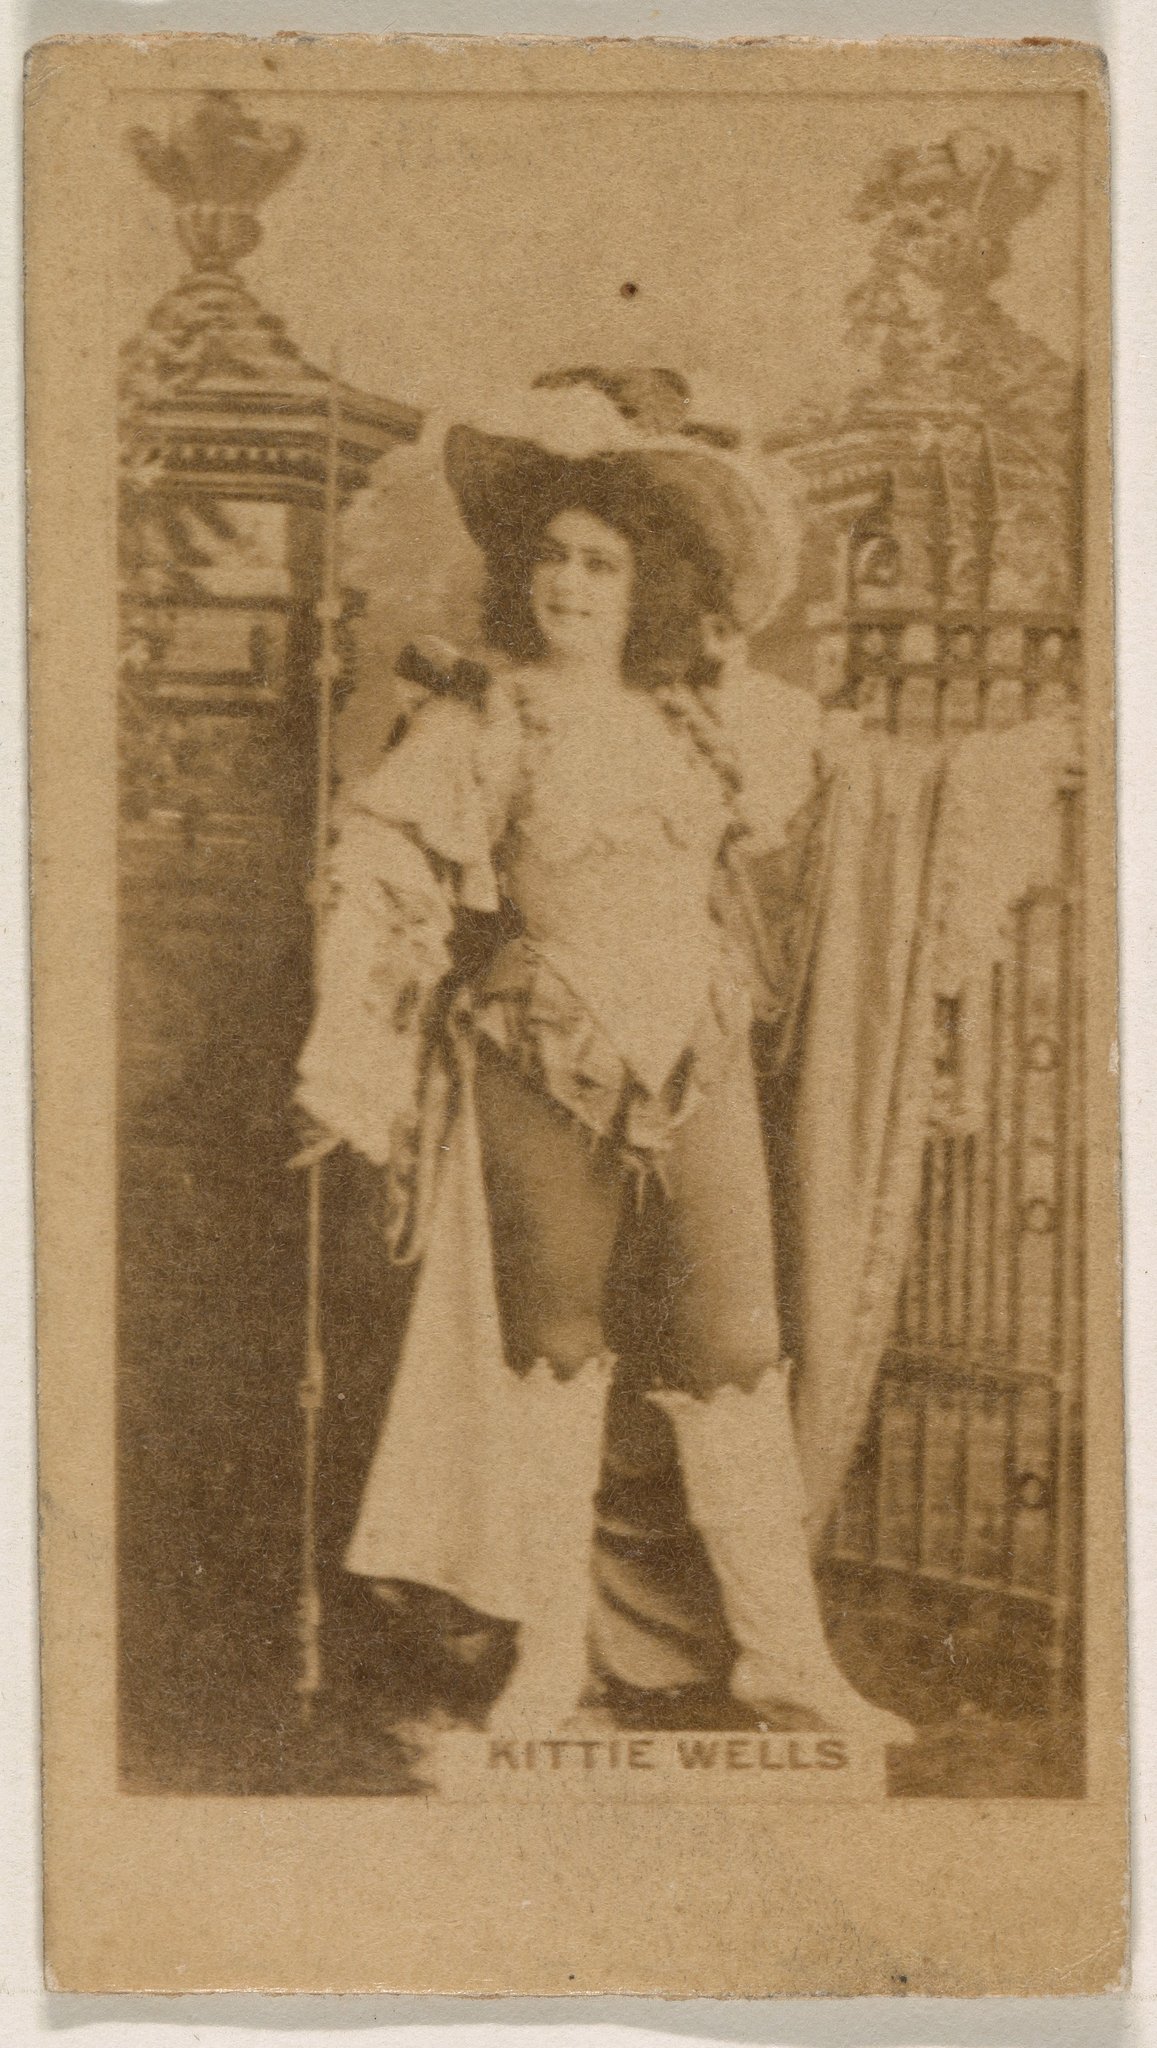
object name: photograph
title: Kittie Wells, from the Actresses series (N245) issued by Kinney Brothers to promote Sweet Caporal Cigarettes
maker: kinney brothers tobacco company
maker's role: publisher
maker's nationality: american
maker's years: 1869-2011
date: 1890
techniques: albumen silver print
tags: portraits,women,actresses